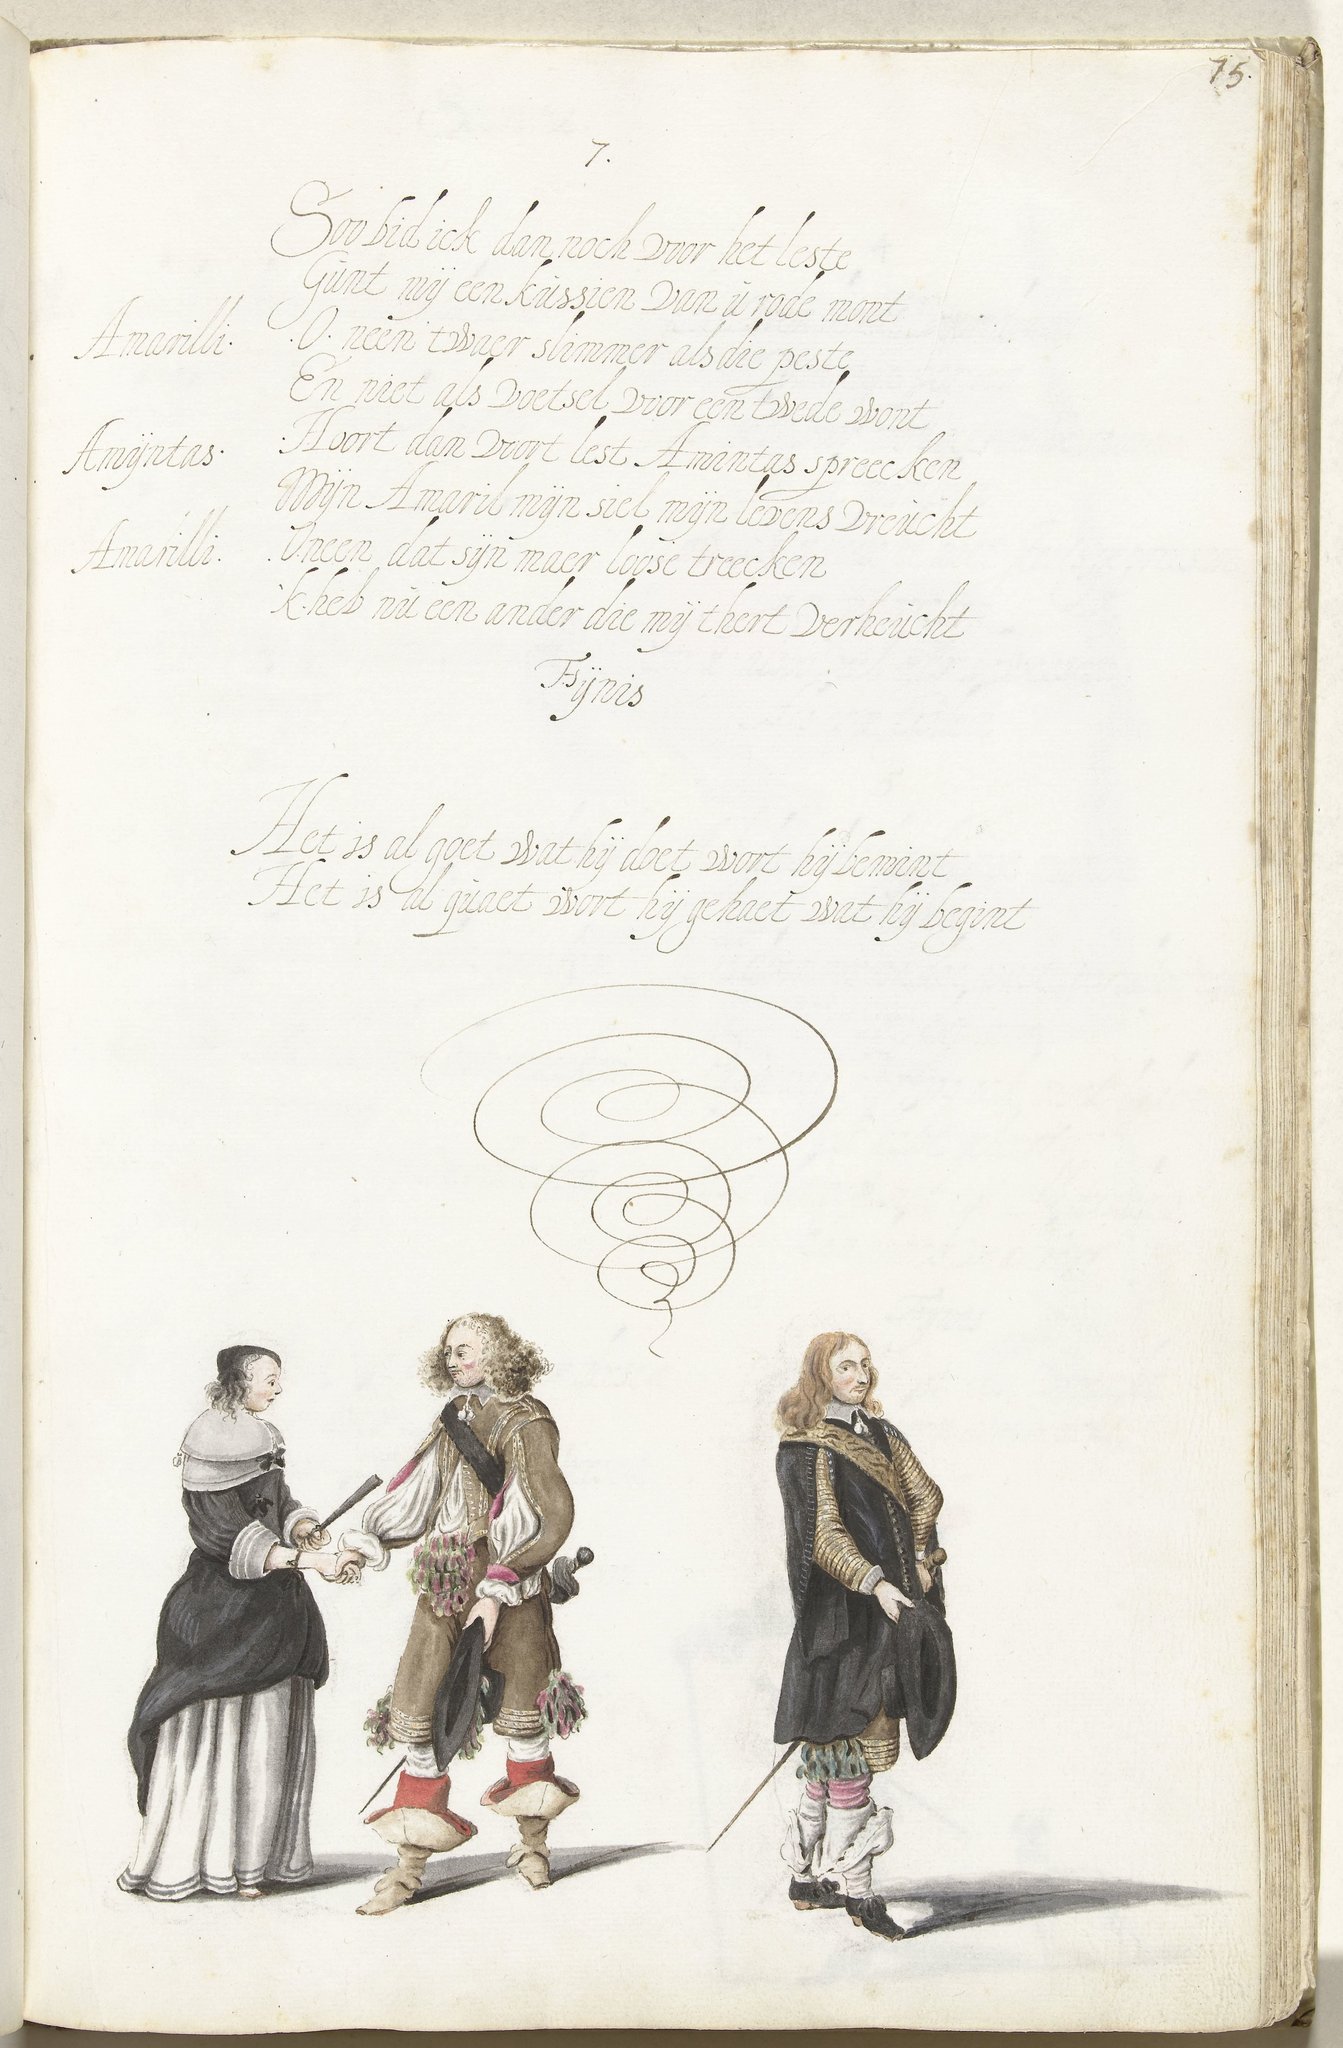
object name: watercolor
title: Stel in gesprek terwijl een tweede heer zich afwendt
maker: gesina ter borch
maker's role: draughtsman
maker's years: 1633-1690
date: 1654-1658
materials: ink, paper, watercolor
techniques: brush, calligraphy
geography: zwolle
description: Pratend stel en een afgewende heer onder vervolg op het gedicht van de vorige pagina (folio 74) met dialoog tussen Amarilli en Amijntas; op de melodie van Cantselaers testament.